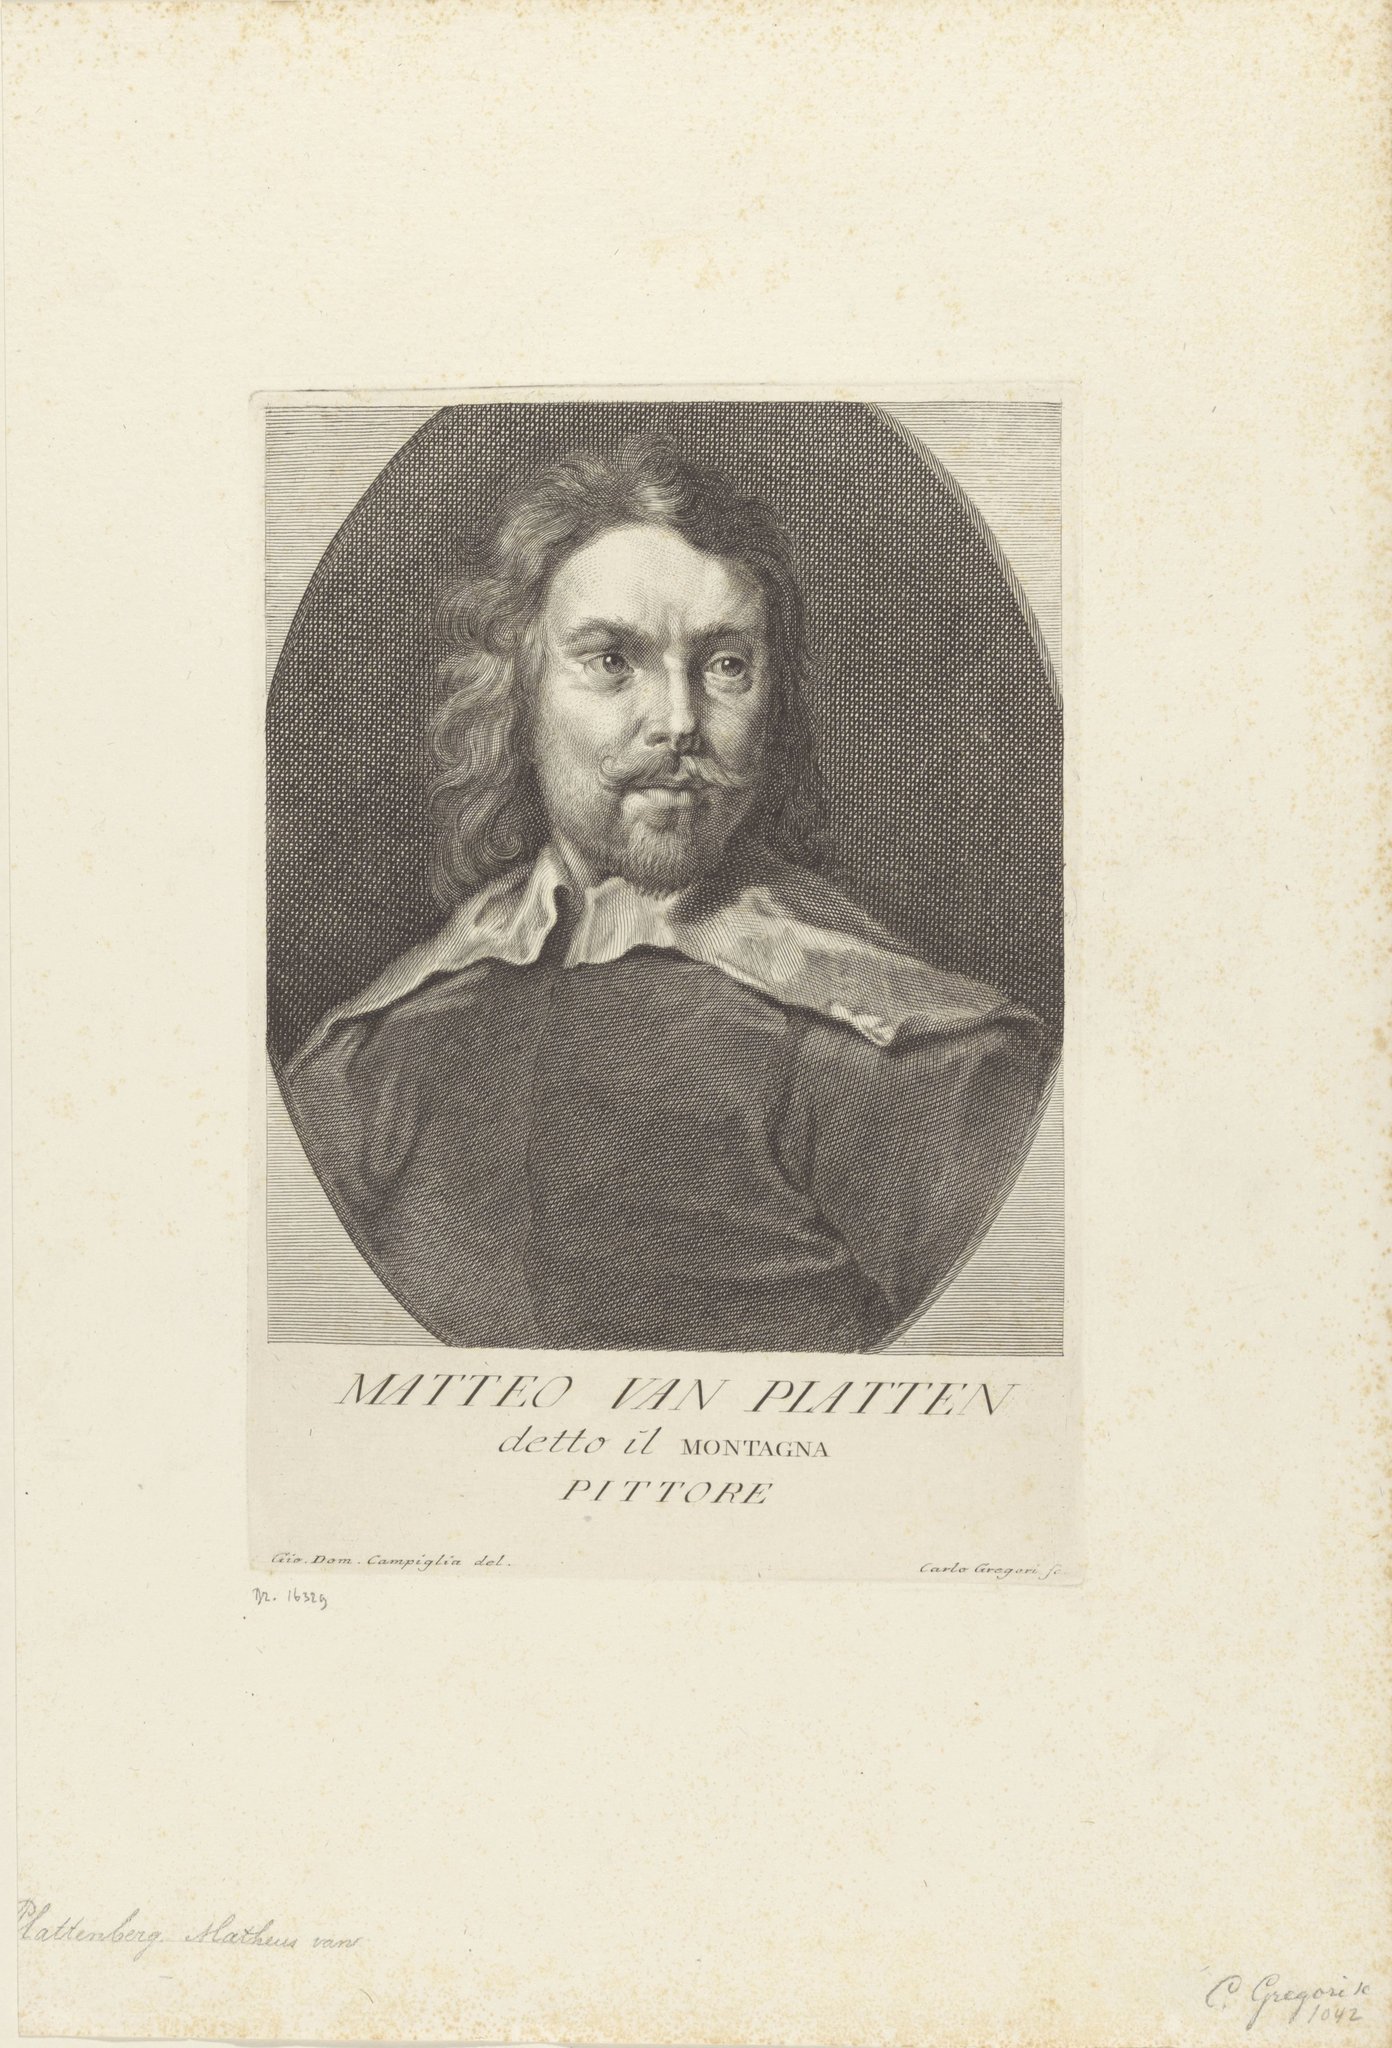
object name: book illustration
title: Portretten van kunstenaars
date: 1752-1762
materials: paper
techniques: engraving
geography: italy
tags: antwerp, print maker, matthieu van plattenberg, historical persons, portrait, self-portrait of artist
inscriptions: collector's mark: Lugt 2760, collector's mark: ‘RIJKS / MUSM’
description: Prent uit: Moücke, Francesco. Serie di ritratti degli eccellenti pittori dipinti di propria mano, che esistono nell'Imiperial Galleria di Firenze. Florence: 1752-1762, dl. III.